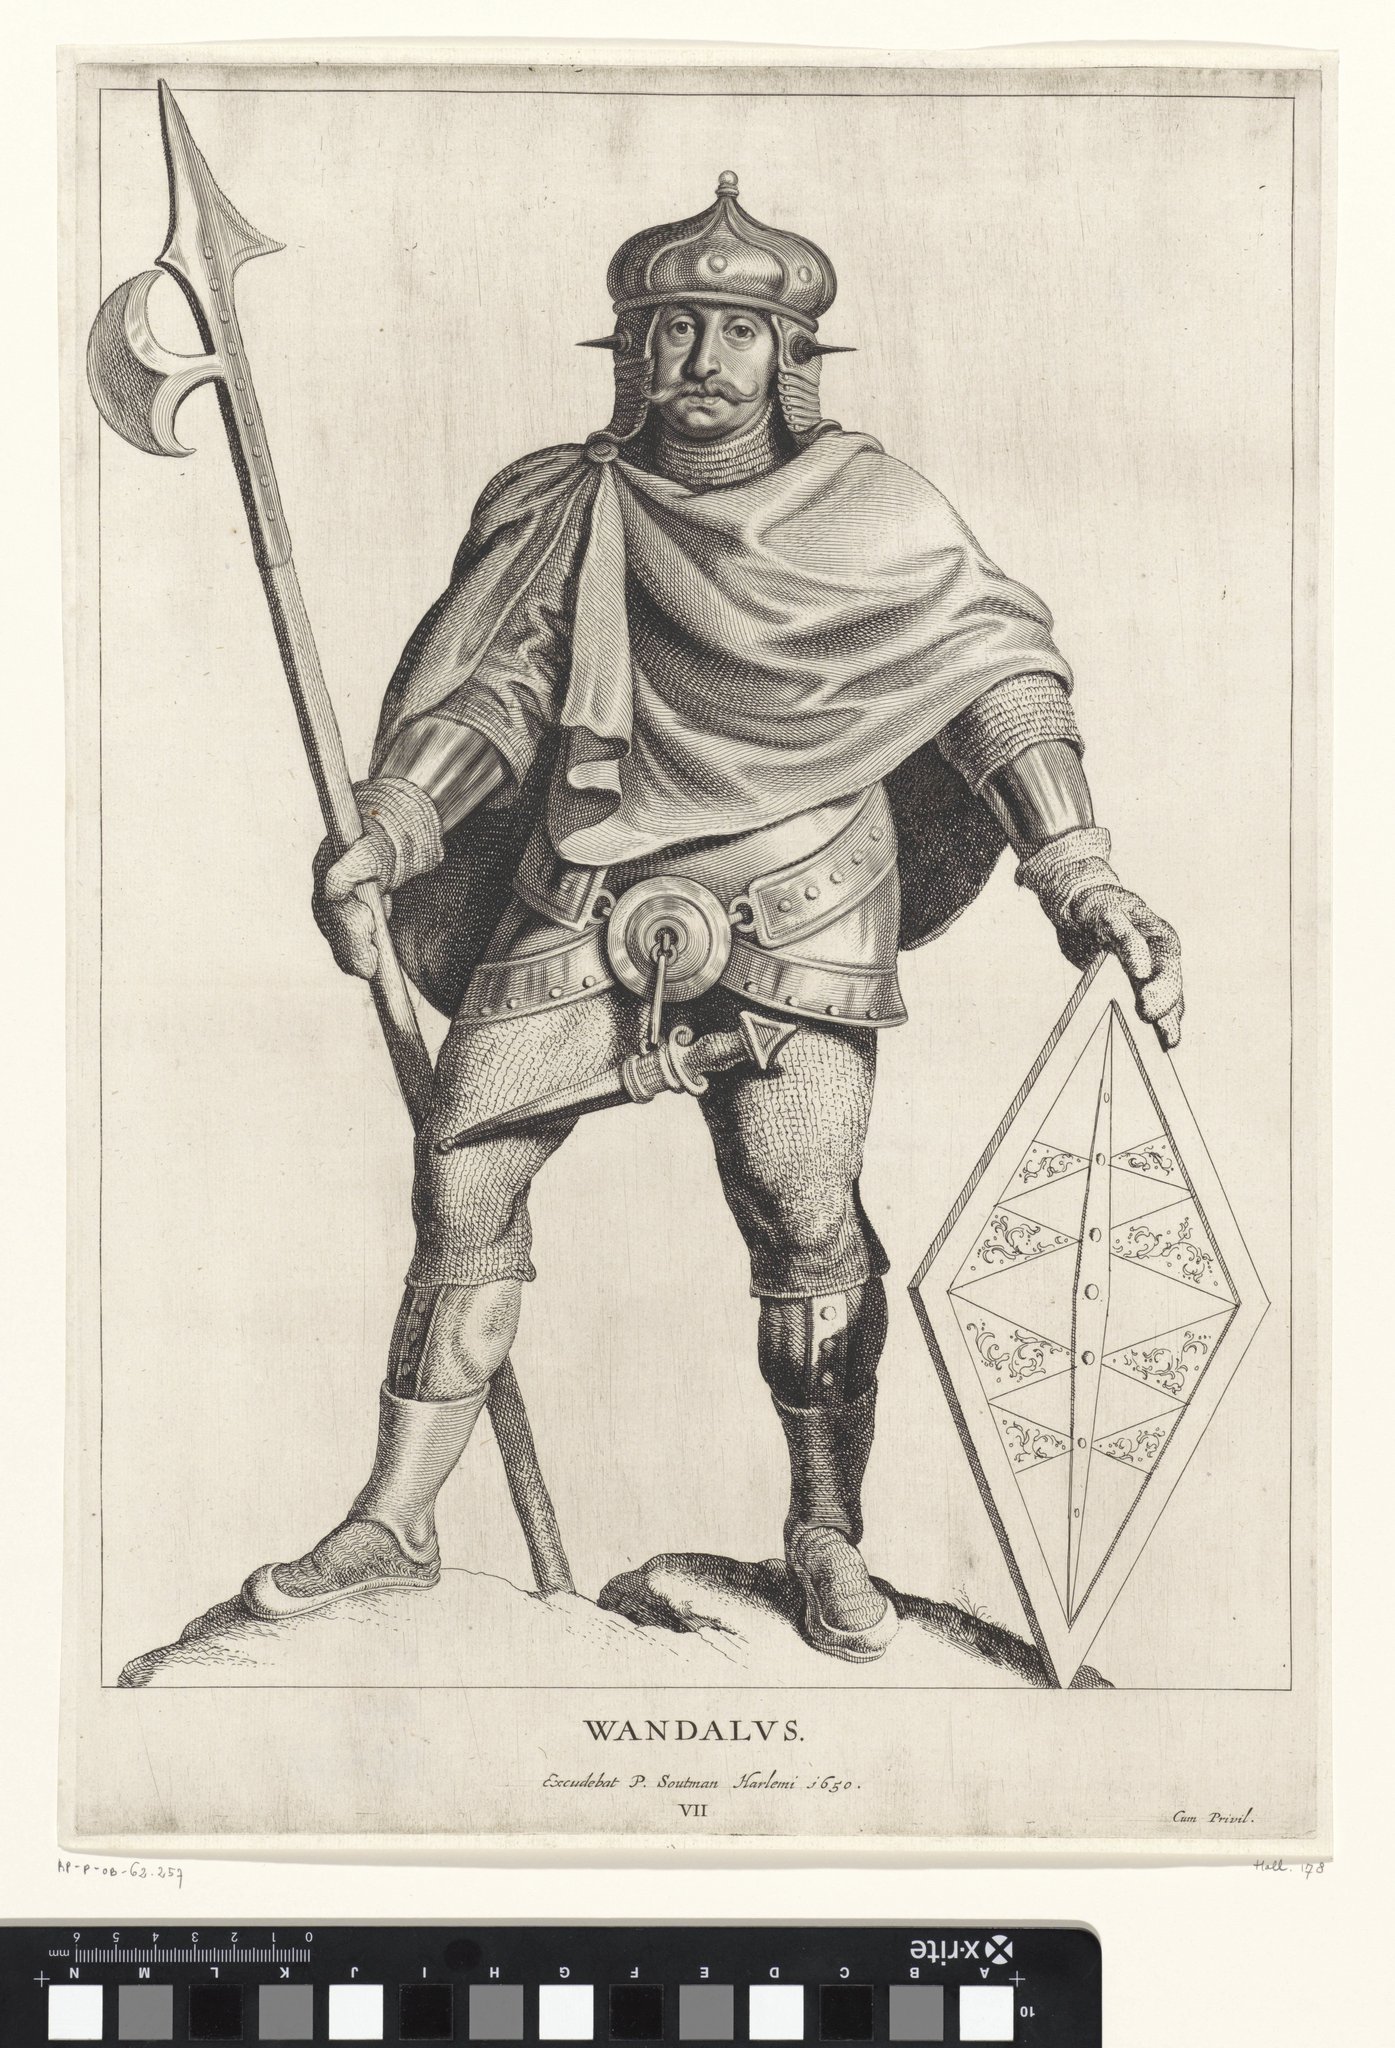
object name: print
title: Oude hier woonachtige volken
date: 1638-1657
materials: paper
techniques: engraving, etching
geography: haarlem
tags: armour, extinct, 'historical' peoples (with name)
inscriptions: collector's mark: Lugt 2228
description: Krijger van het Germaanse volk der Vandalen, staande ten voeten uit, gewapend met hellebaard en schild.